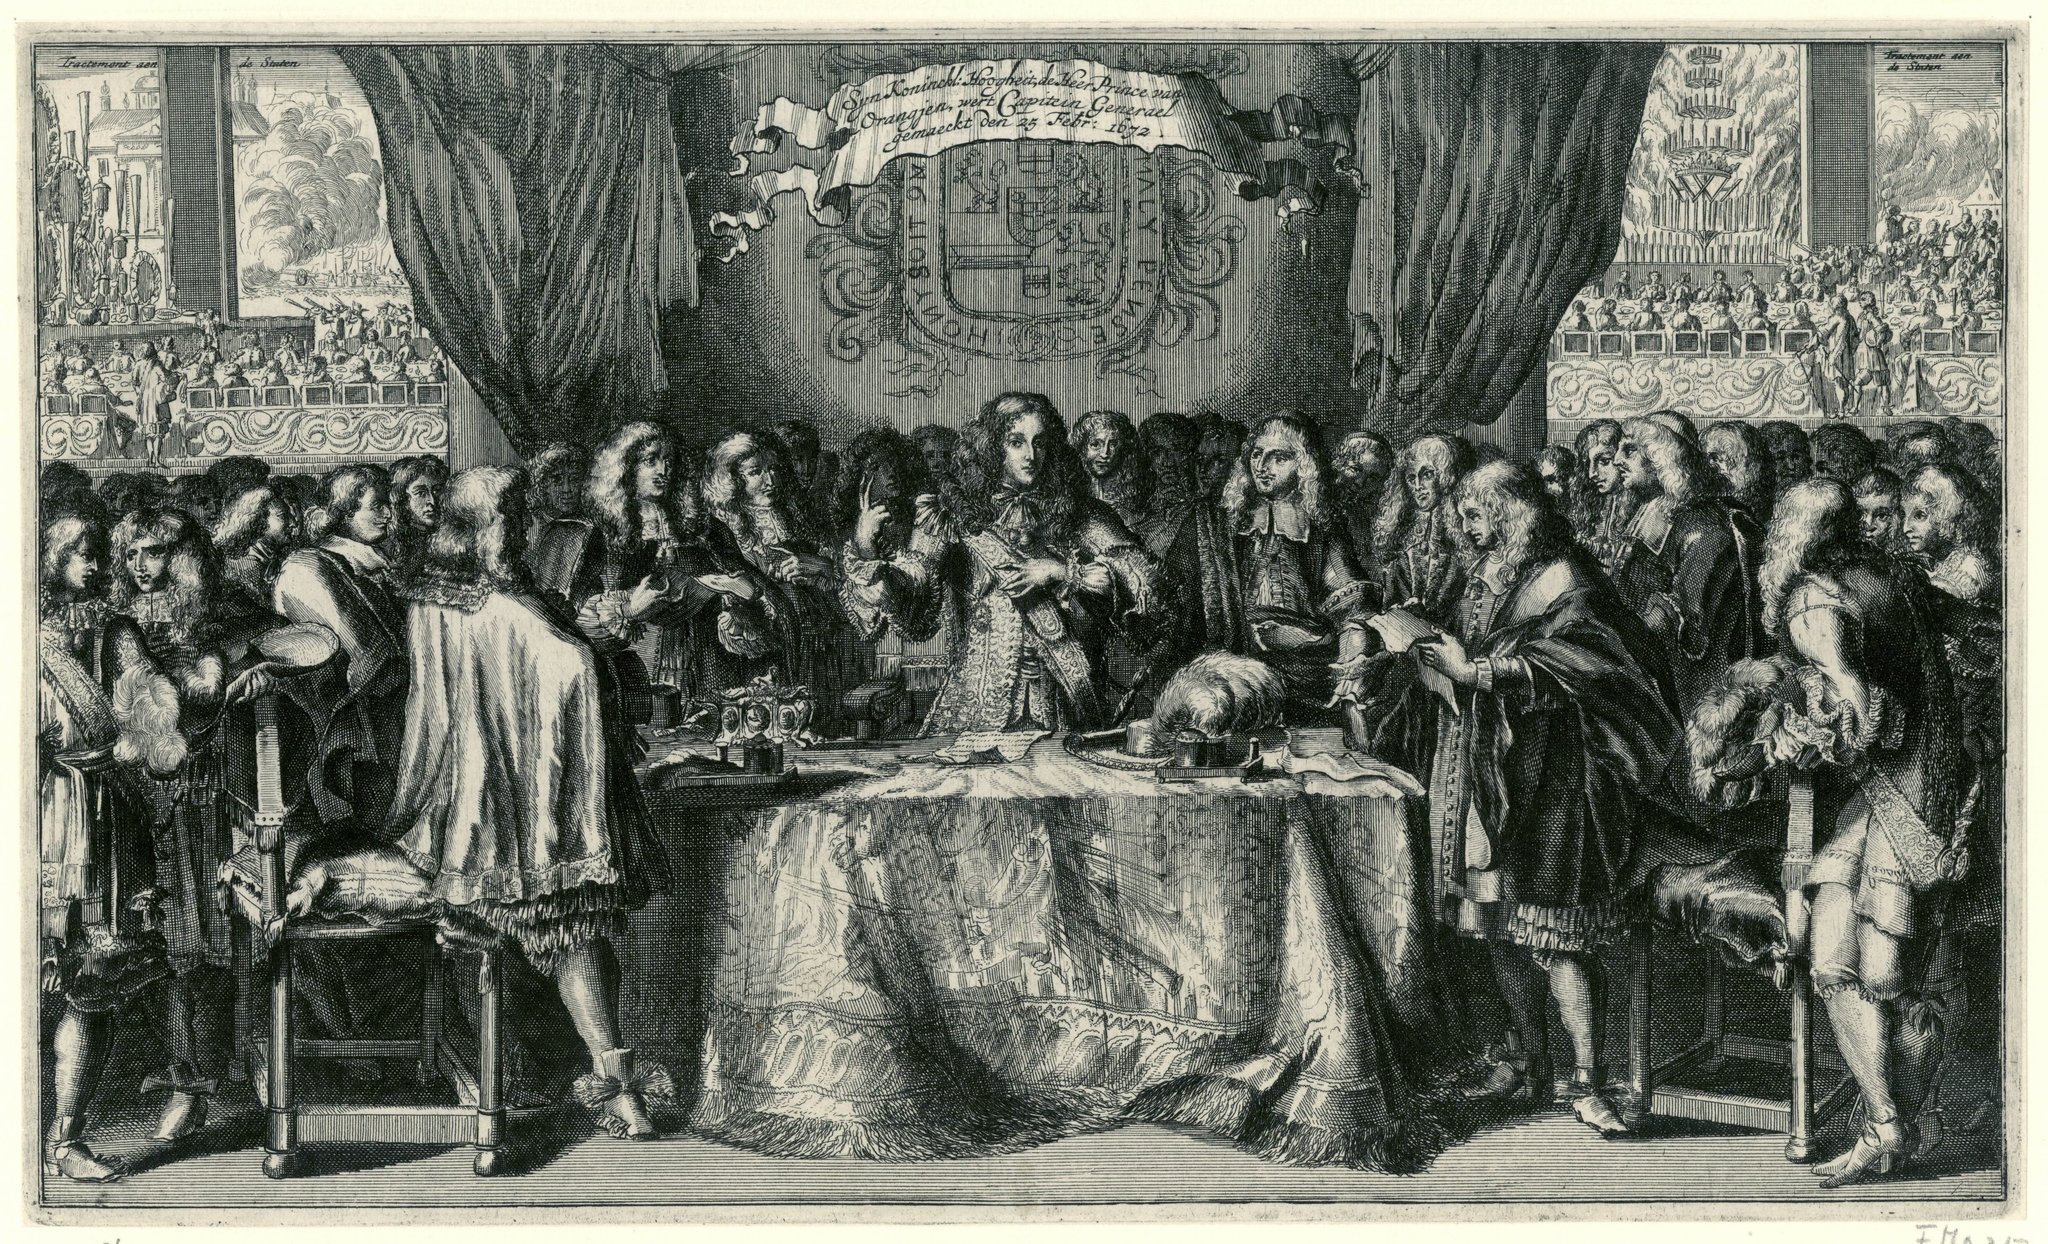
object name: print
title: Willem III ingezworen als kapitein-generaal, 1672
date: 1672-1685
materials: paper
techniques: etching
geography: northern netherlands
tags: the hague, william iii (prince of orange and king of england, scotland, and ireland), politician, gaspar fagel, swearing an oath (with two fingers raised), taking the oath ~ military service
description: Illustratie voor: Lambert van den Bosch, Tooneel des oorlogs, opgerecht in de Vereenigde Nederlanden door de wapenen van de koningen van Vrankryk en Engeland, Keulsche en Munstersche bisschoppen : tegen de Staten der Vereenigde Nederlanden, en hare geallieerden, J. van Meurs en J. van Someren, Amsterdam 1675, 4 delen, dl. 2, fol. 34. De prent is een verkleinde herhaling van een andere voorstelling van deze gebeurtenis door Romeyn de Hooghe (FMH 2316).